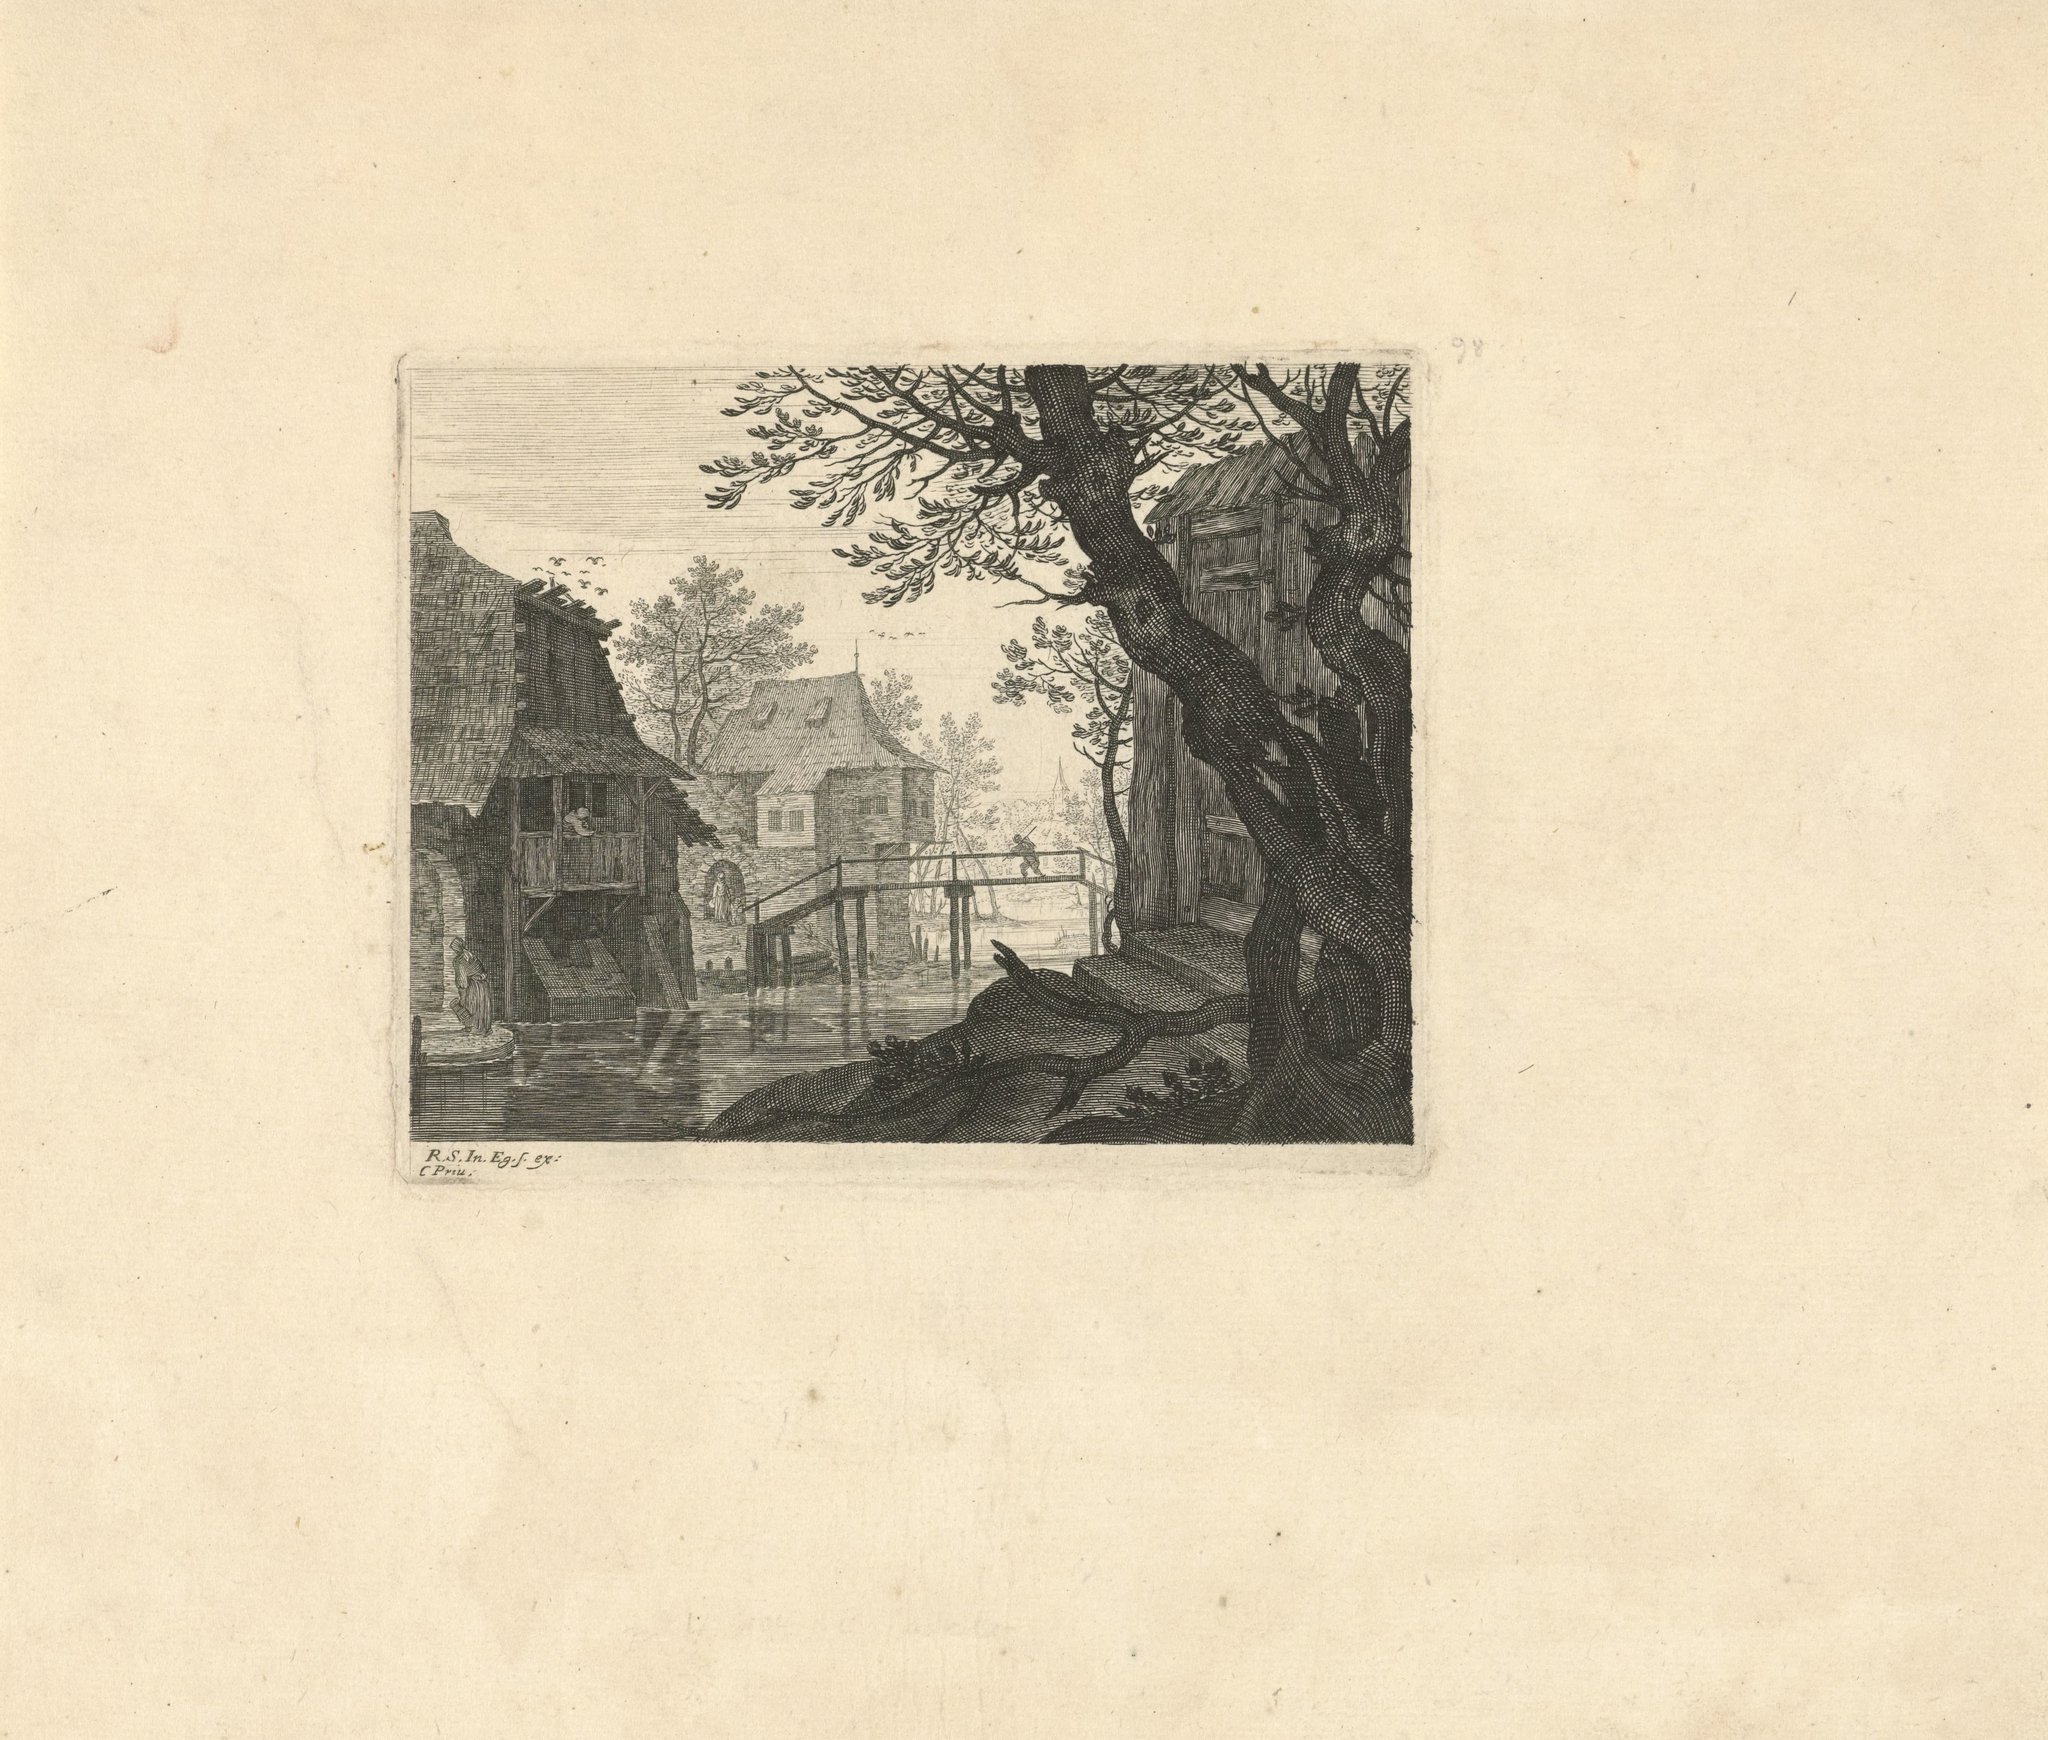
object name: print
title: Brug over een dorpskanaal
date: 1597-1629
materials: paper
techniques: engraving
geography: prague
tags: bridge in village across river, canal, etc. (+ city(-scape) with figures, staffage)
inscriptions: collector's mark: Lugt 2760, collector's mark: Lugt 2228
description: Een dorpskanaal met langs twee kanten huizen. Op de achtergrond een brug met een reiziger. De laatste prent van een zesdelige reeks met landschappen in Tirol